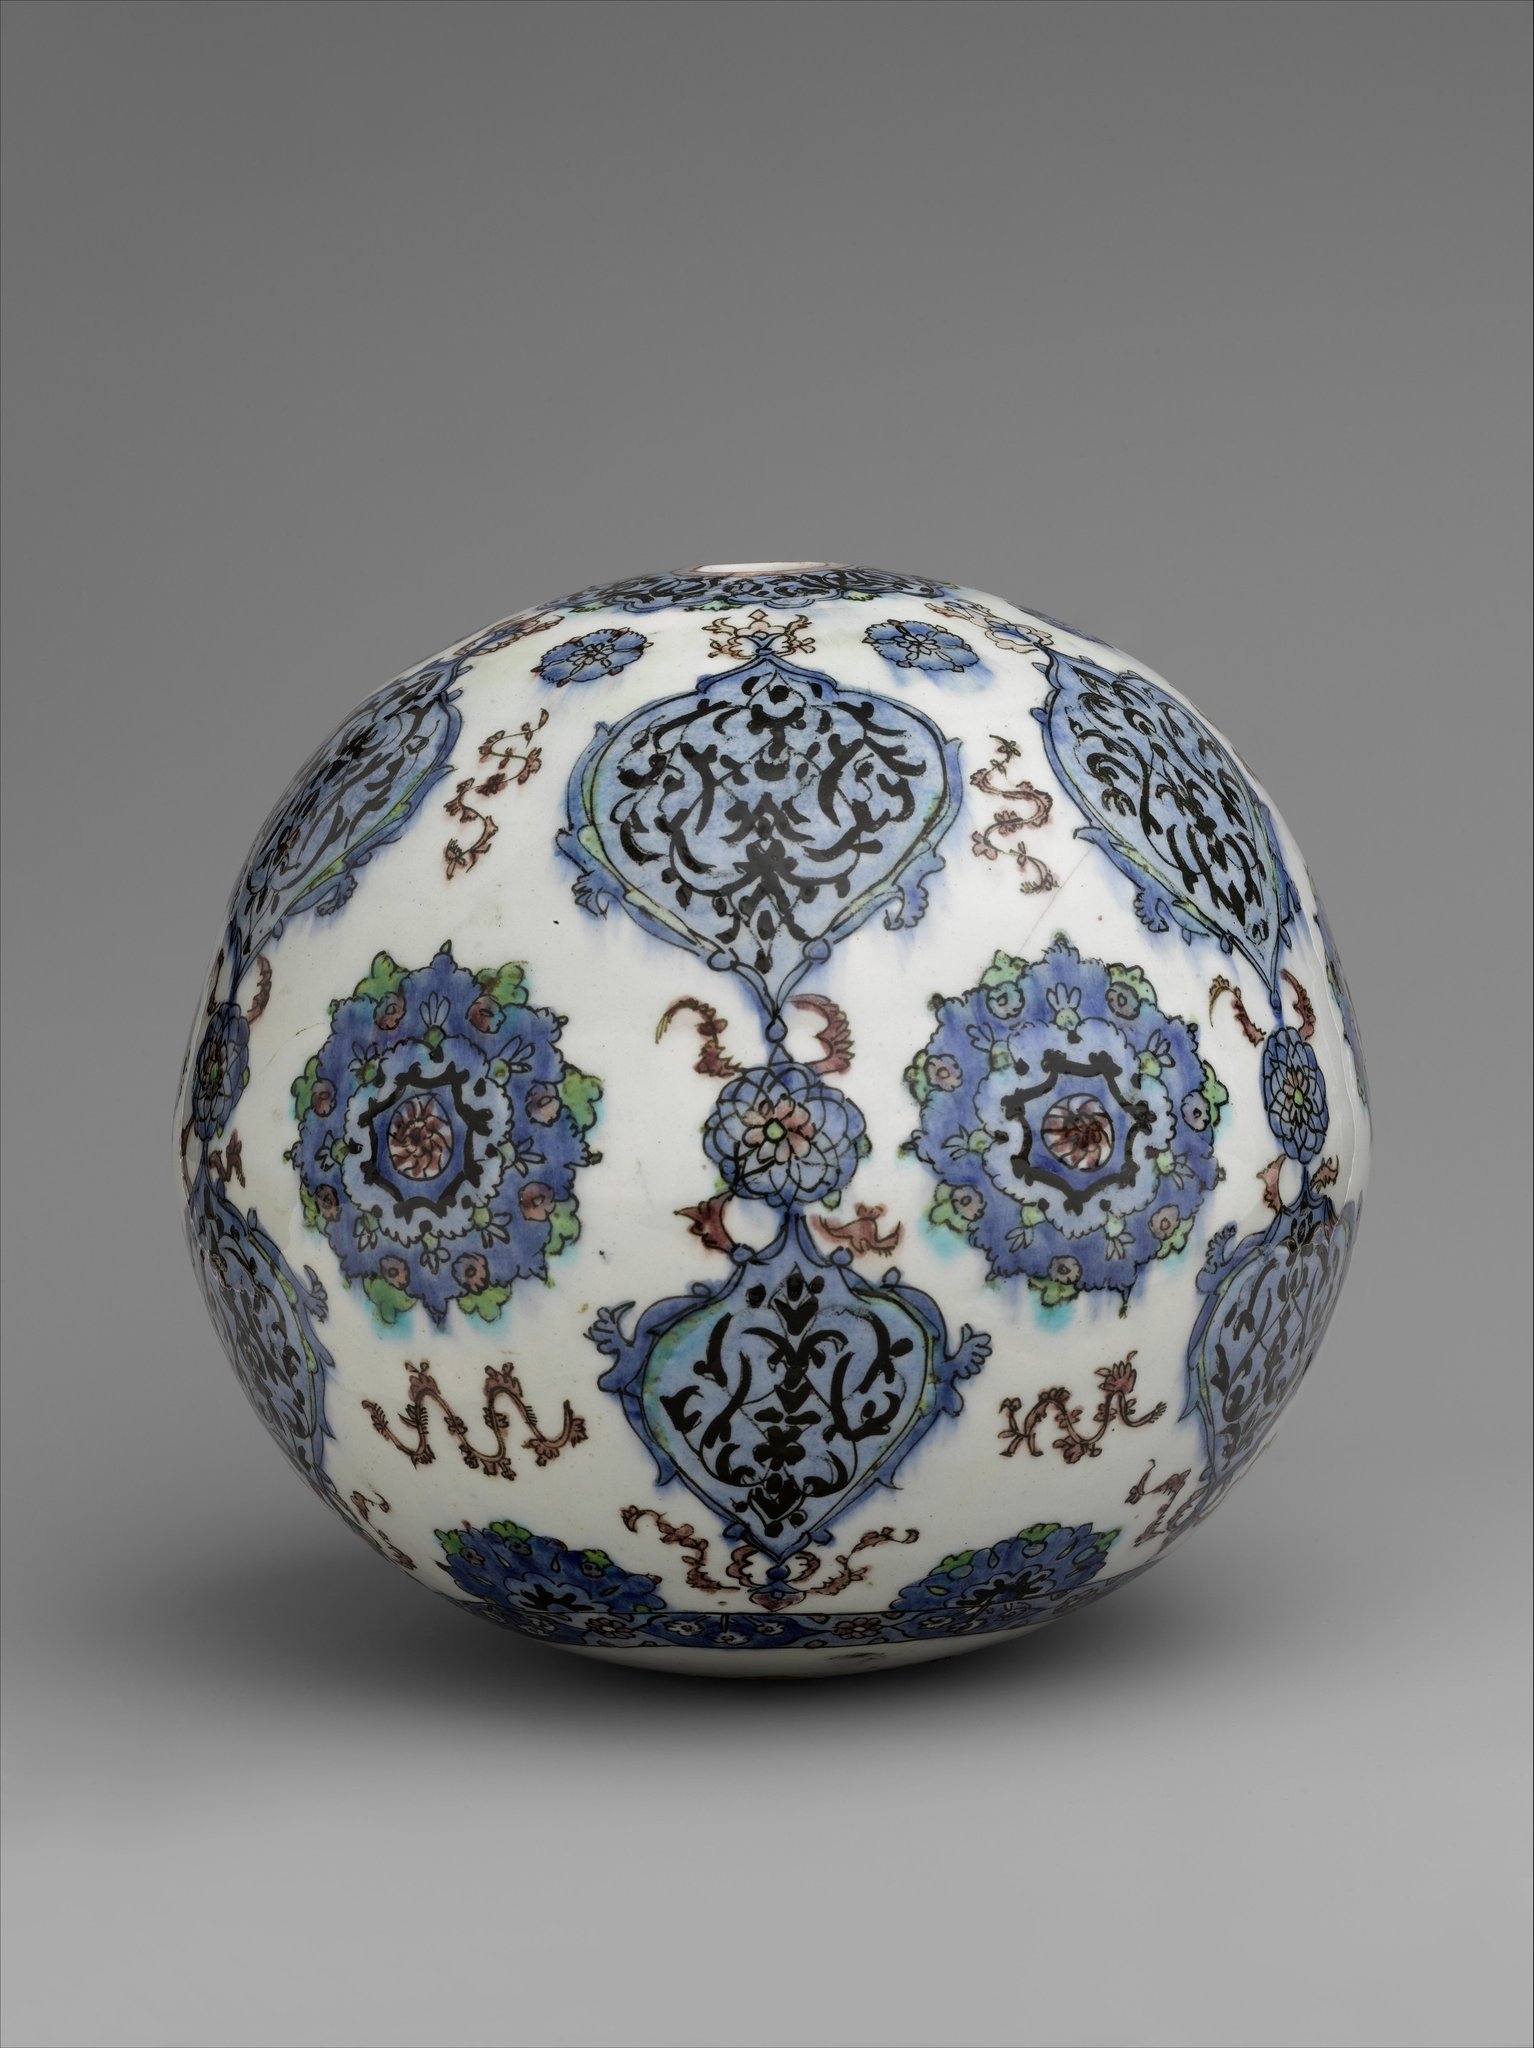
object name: ornament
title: Hanging Ornament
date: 1801-1900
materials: glaze, stonepaste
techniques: painting, polychrome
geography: turkey